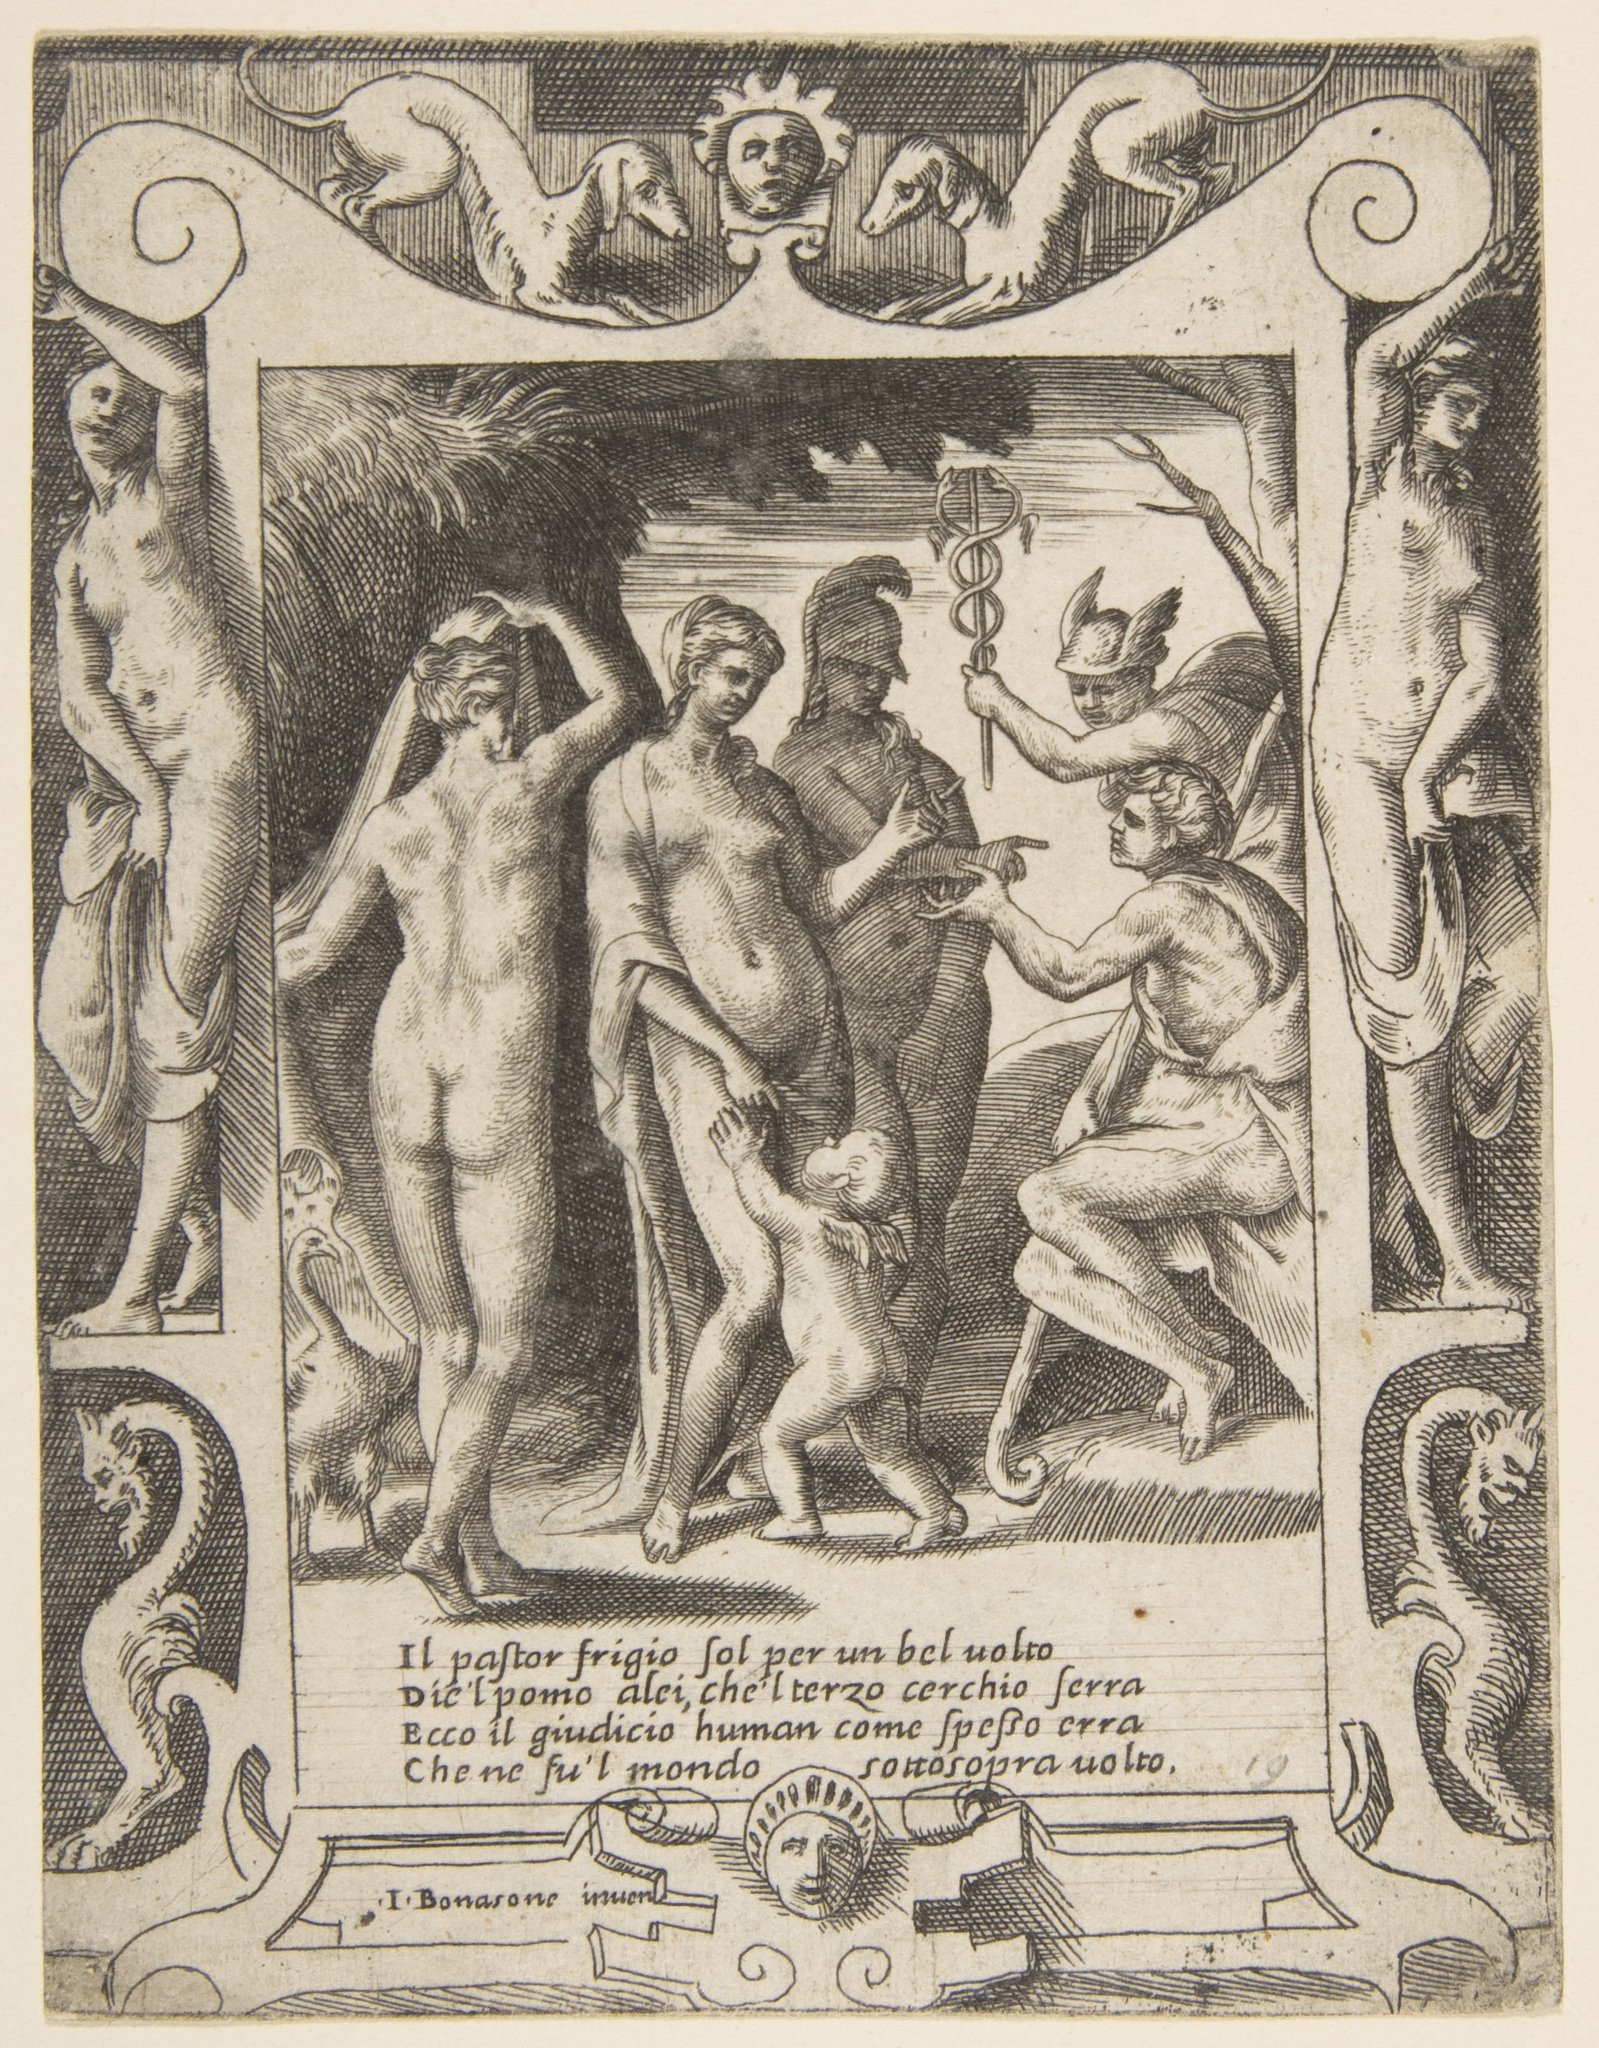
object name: print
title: The judgment of Paris, set within an elaborate frame, from "Loves, Rages and Jealousies of Juno"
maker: giulio bonasone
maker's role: artist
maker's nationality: italian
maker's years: 1510-1576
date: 1531-1576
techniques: engraving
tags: female nudes,juno